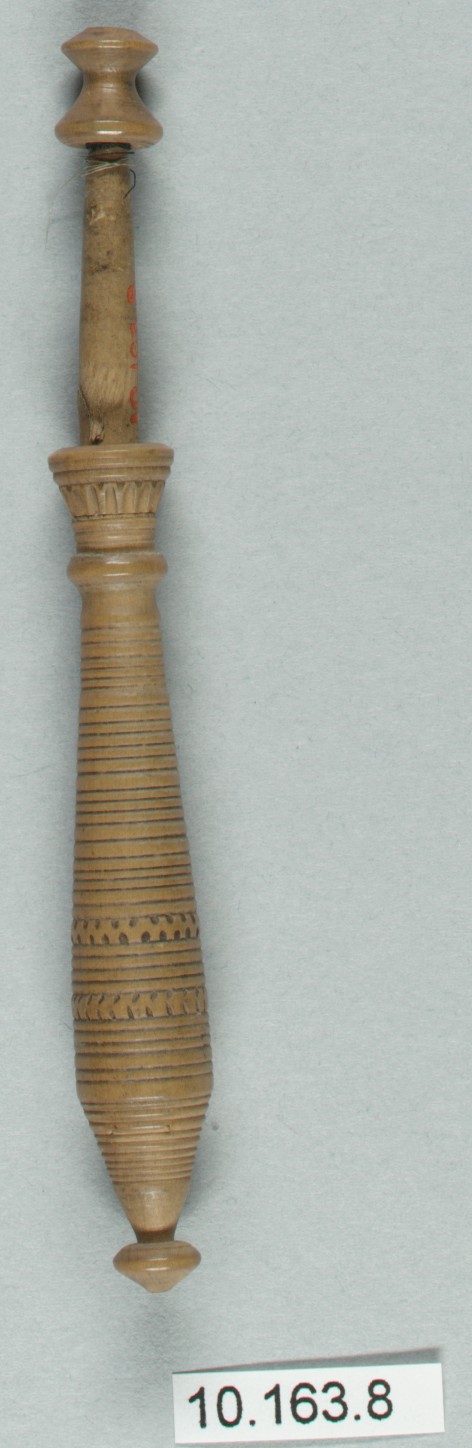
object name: bobbin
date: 1801-1900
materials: wood